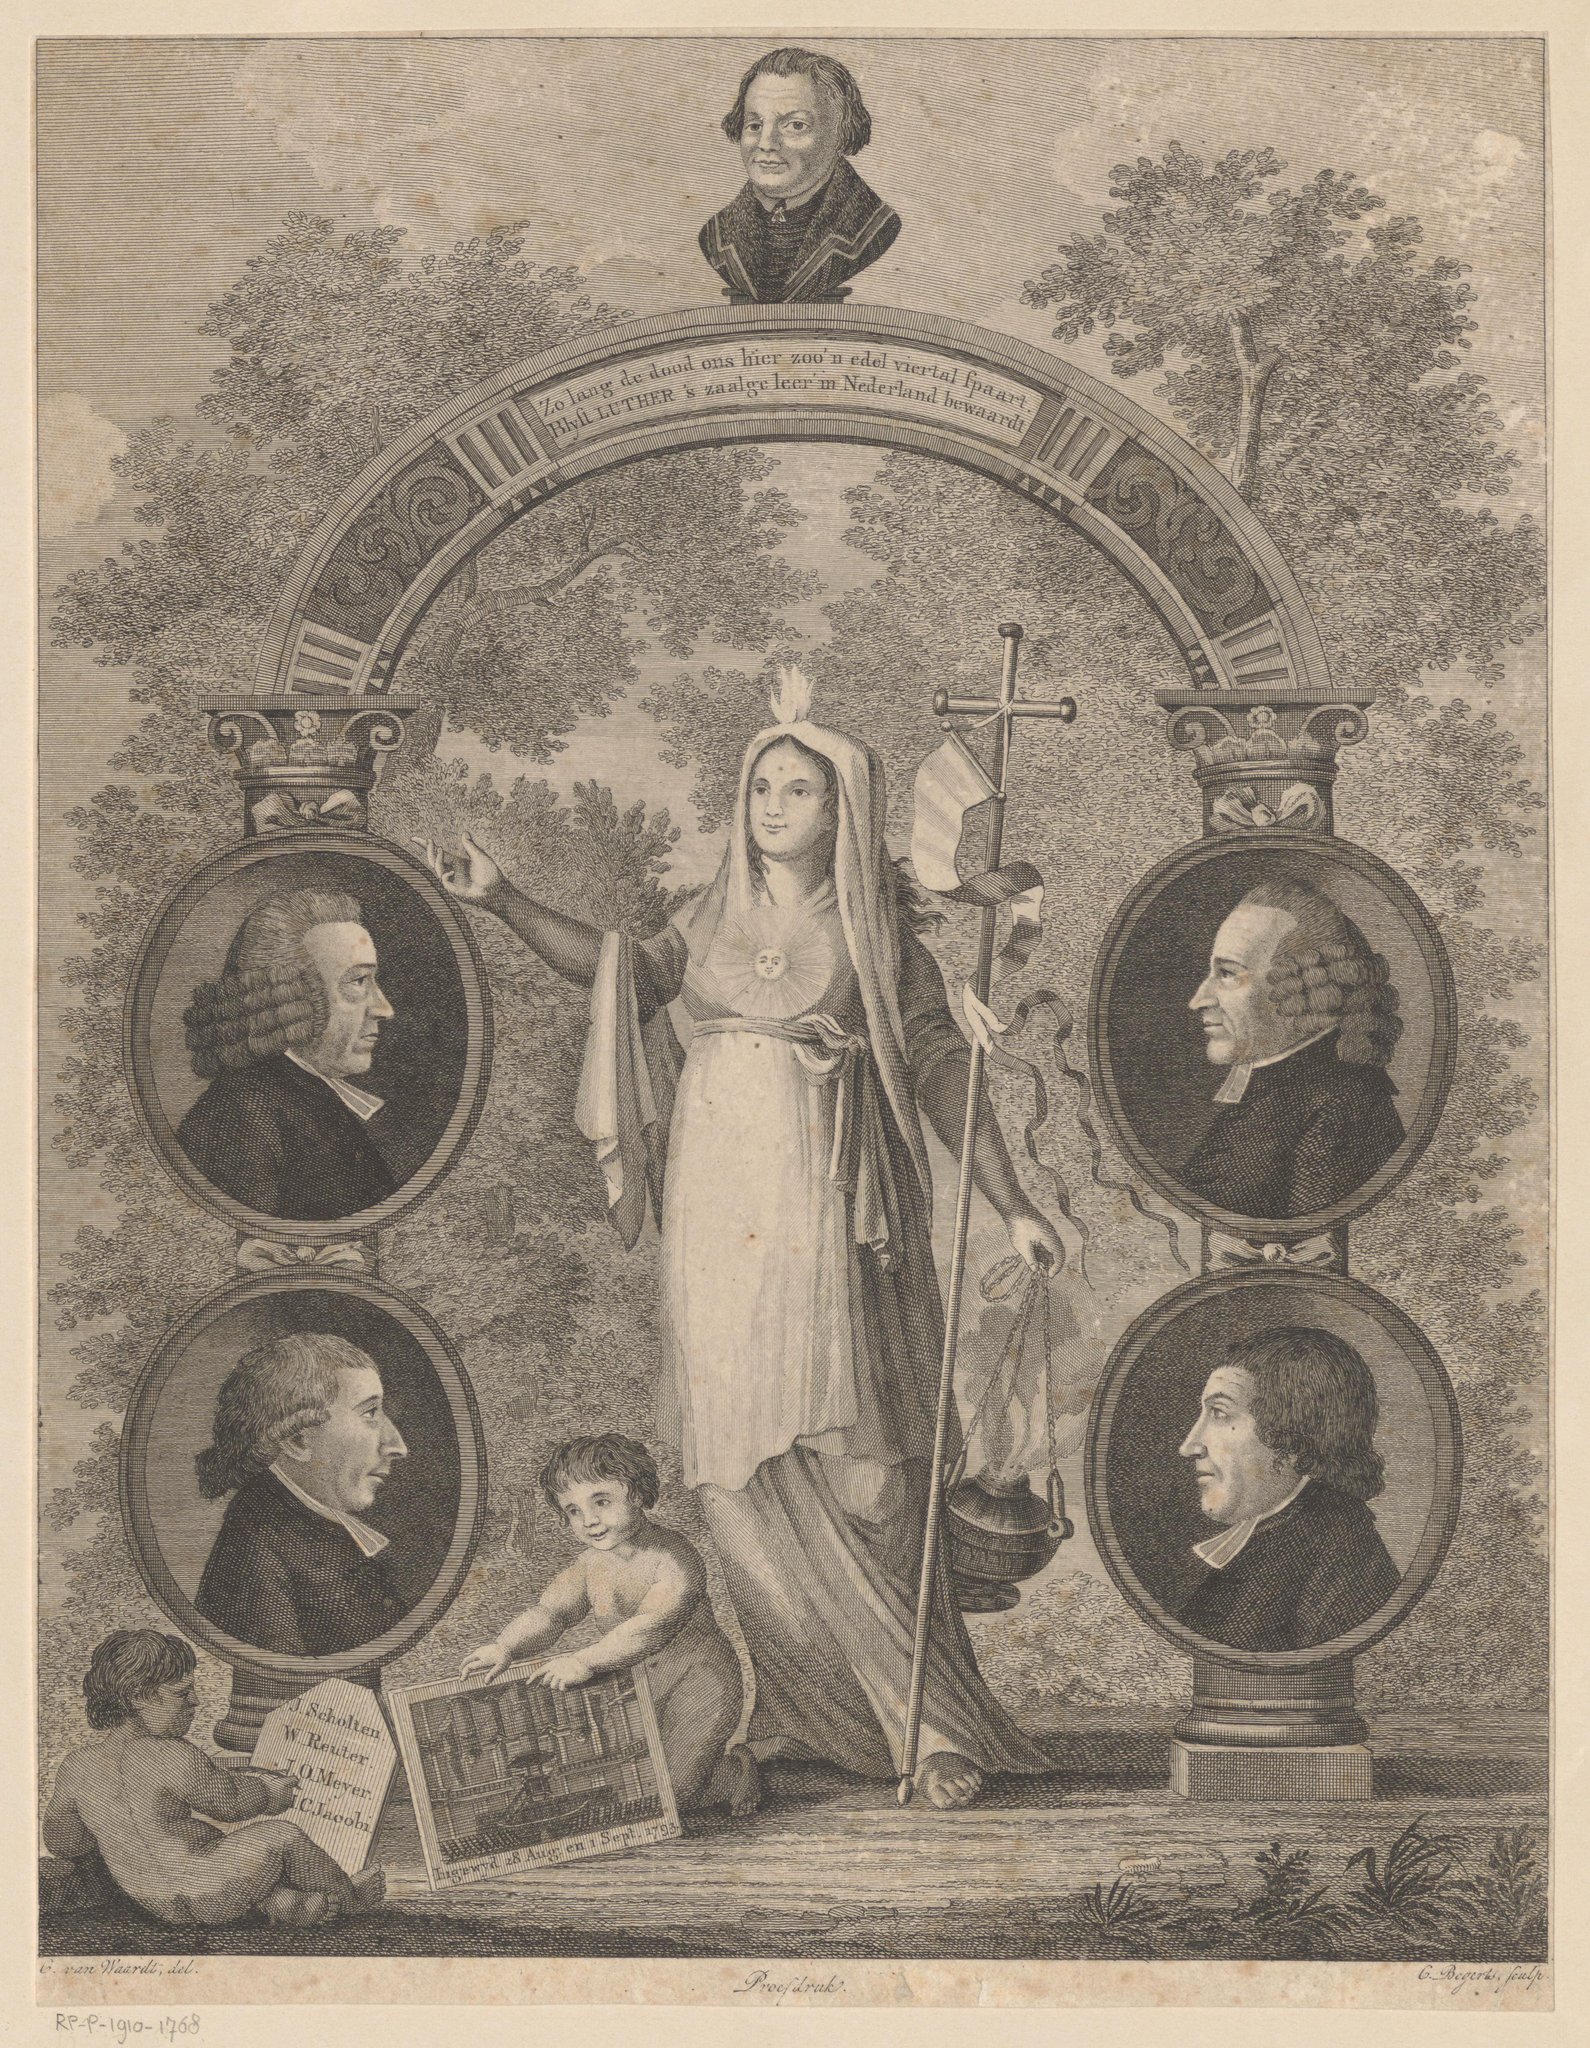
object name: print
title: Allegorische voorstelling met portretten van vier Lutherse predikanten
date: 1793-1817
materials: paper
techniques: etching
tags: priest, martin luther, historical persons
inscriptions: collector's mark: Lugt 2228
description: In het midden staat Geloof onder een boog met daarop een buste van Martin Luther. Hier omheen de portretten van Isaac Scholten, Wilhelm Reuter, Johann Otto Meyer en Jan Coenraad Jacobi.